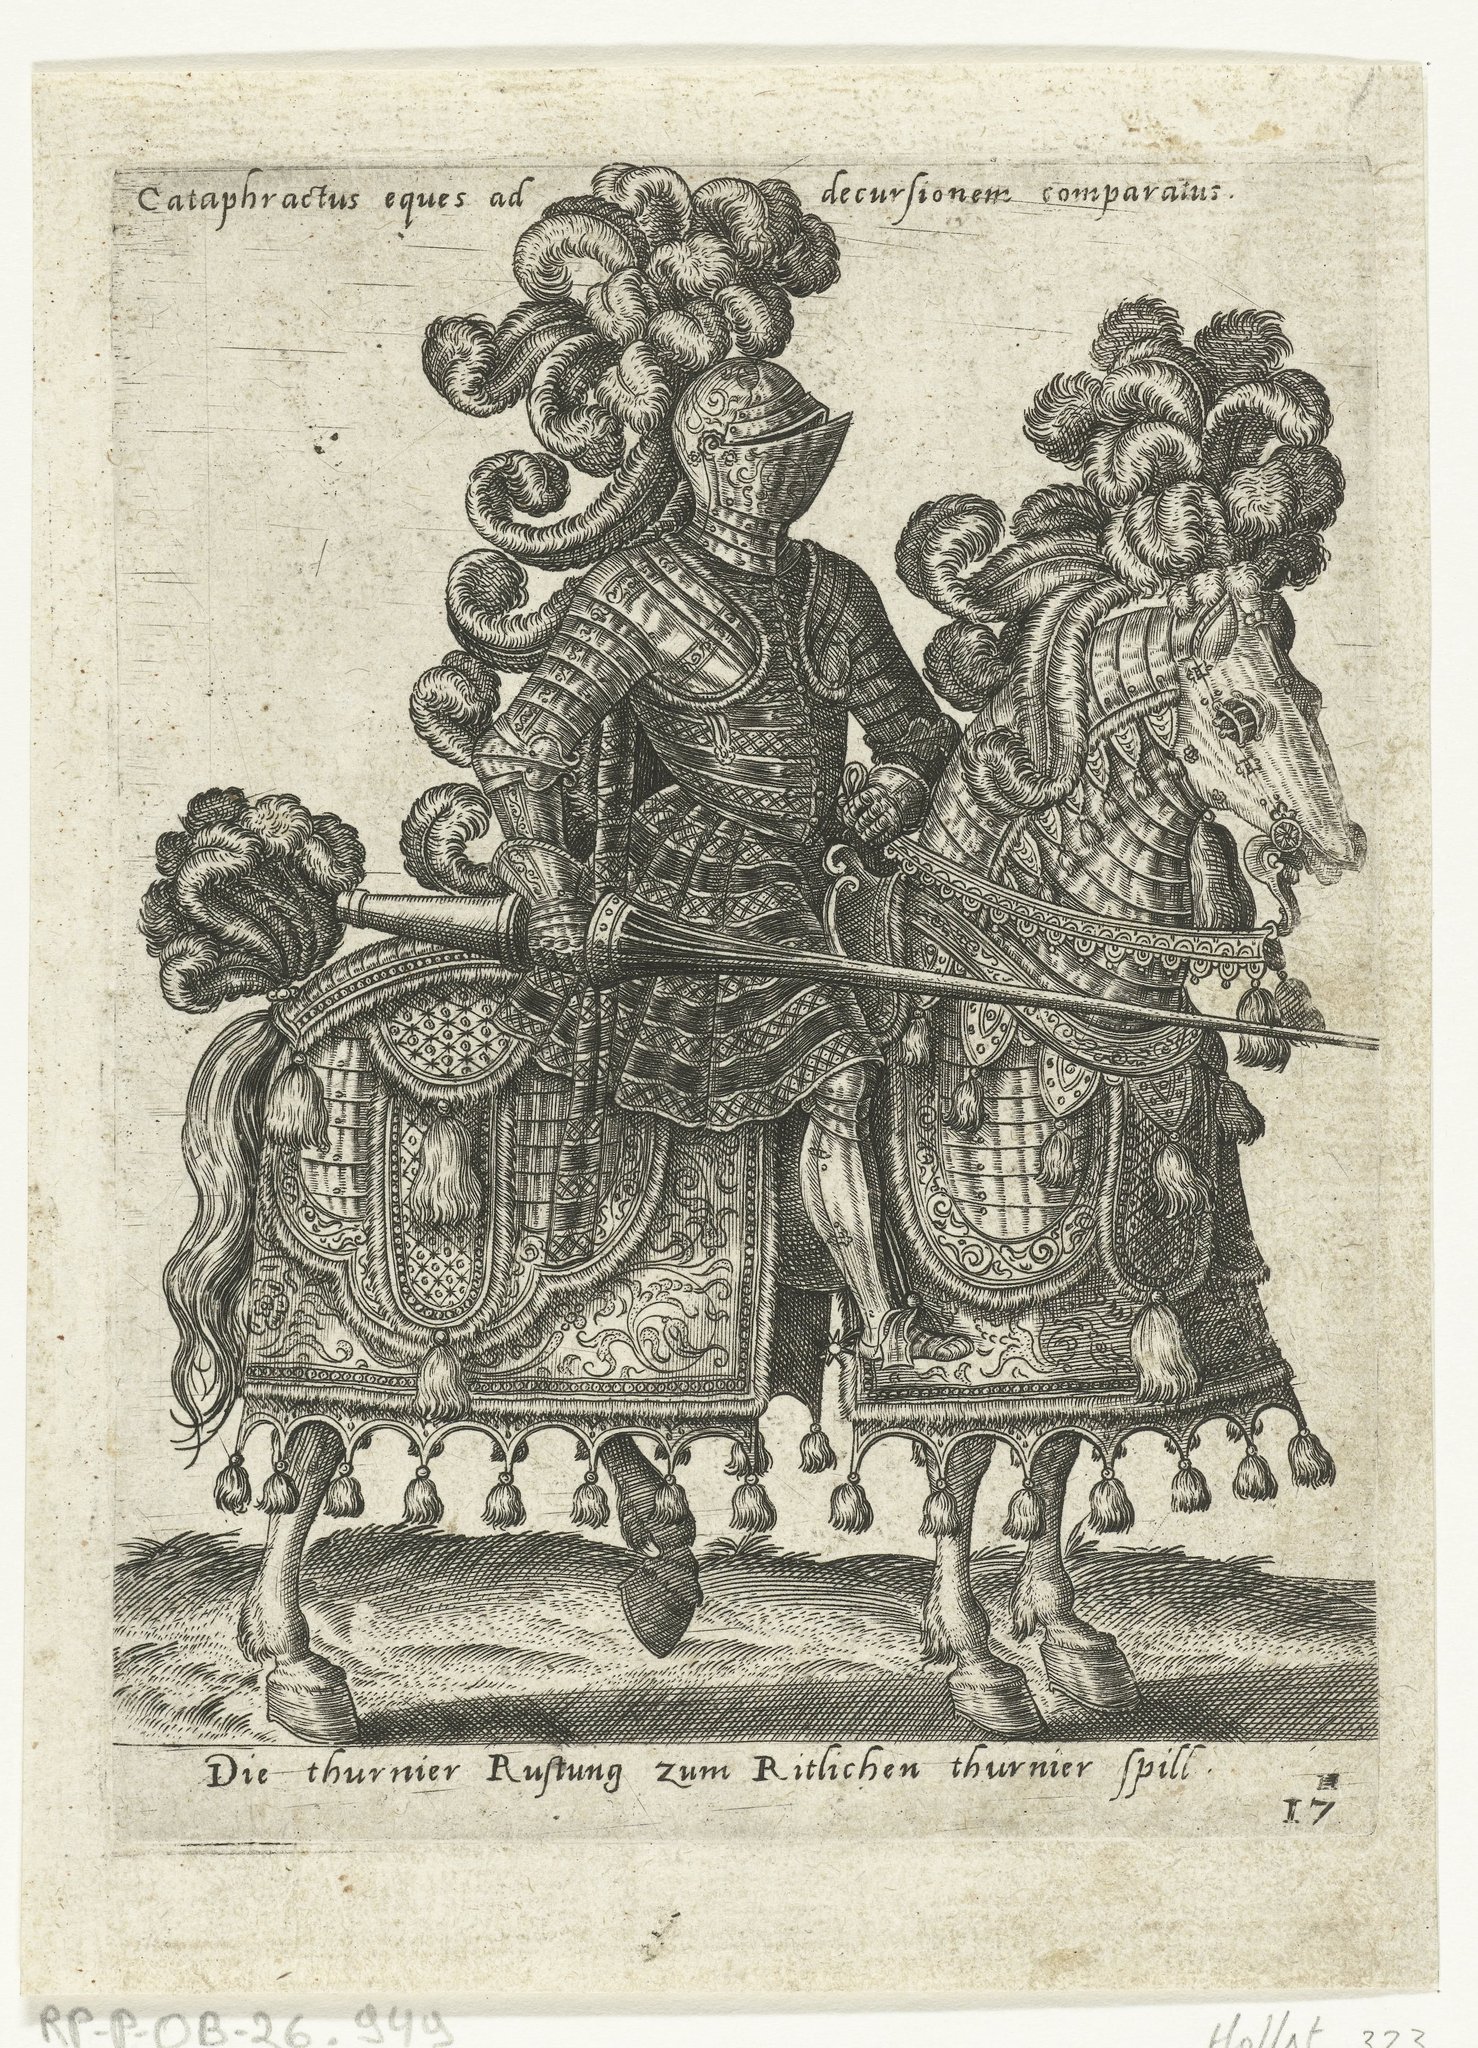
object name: costume print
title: Toernooiridder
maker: abraham de bruyn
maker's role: print maker, publisher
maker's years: 1540-1587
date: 1577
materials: paper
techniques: engraving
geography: cologne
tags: warfare; military affairs (+ cavalry, horsemen), joust, tilt, folk costume, regional costume, knight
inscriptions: collector's mark: Lugt 2228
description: Prent oorspronkelijk verschenen in 'Equitum descripcio, quomodo equestres copie, nostra hac aetate, in sua armatura, per cunttas, videlicet Europae, Asiae et Affrice, nationes in re militare sese habent nunc primum', Keulen 1577.